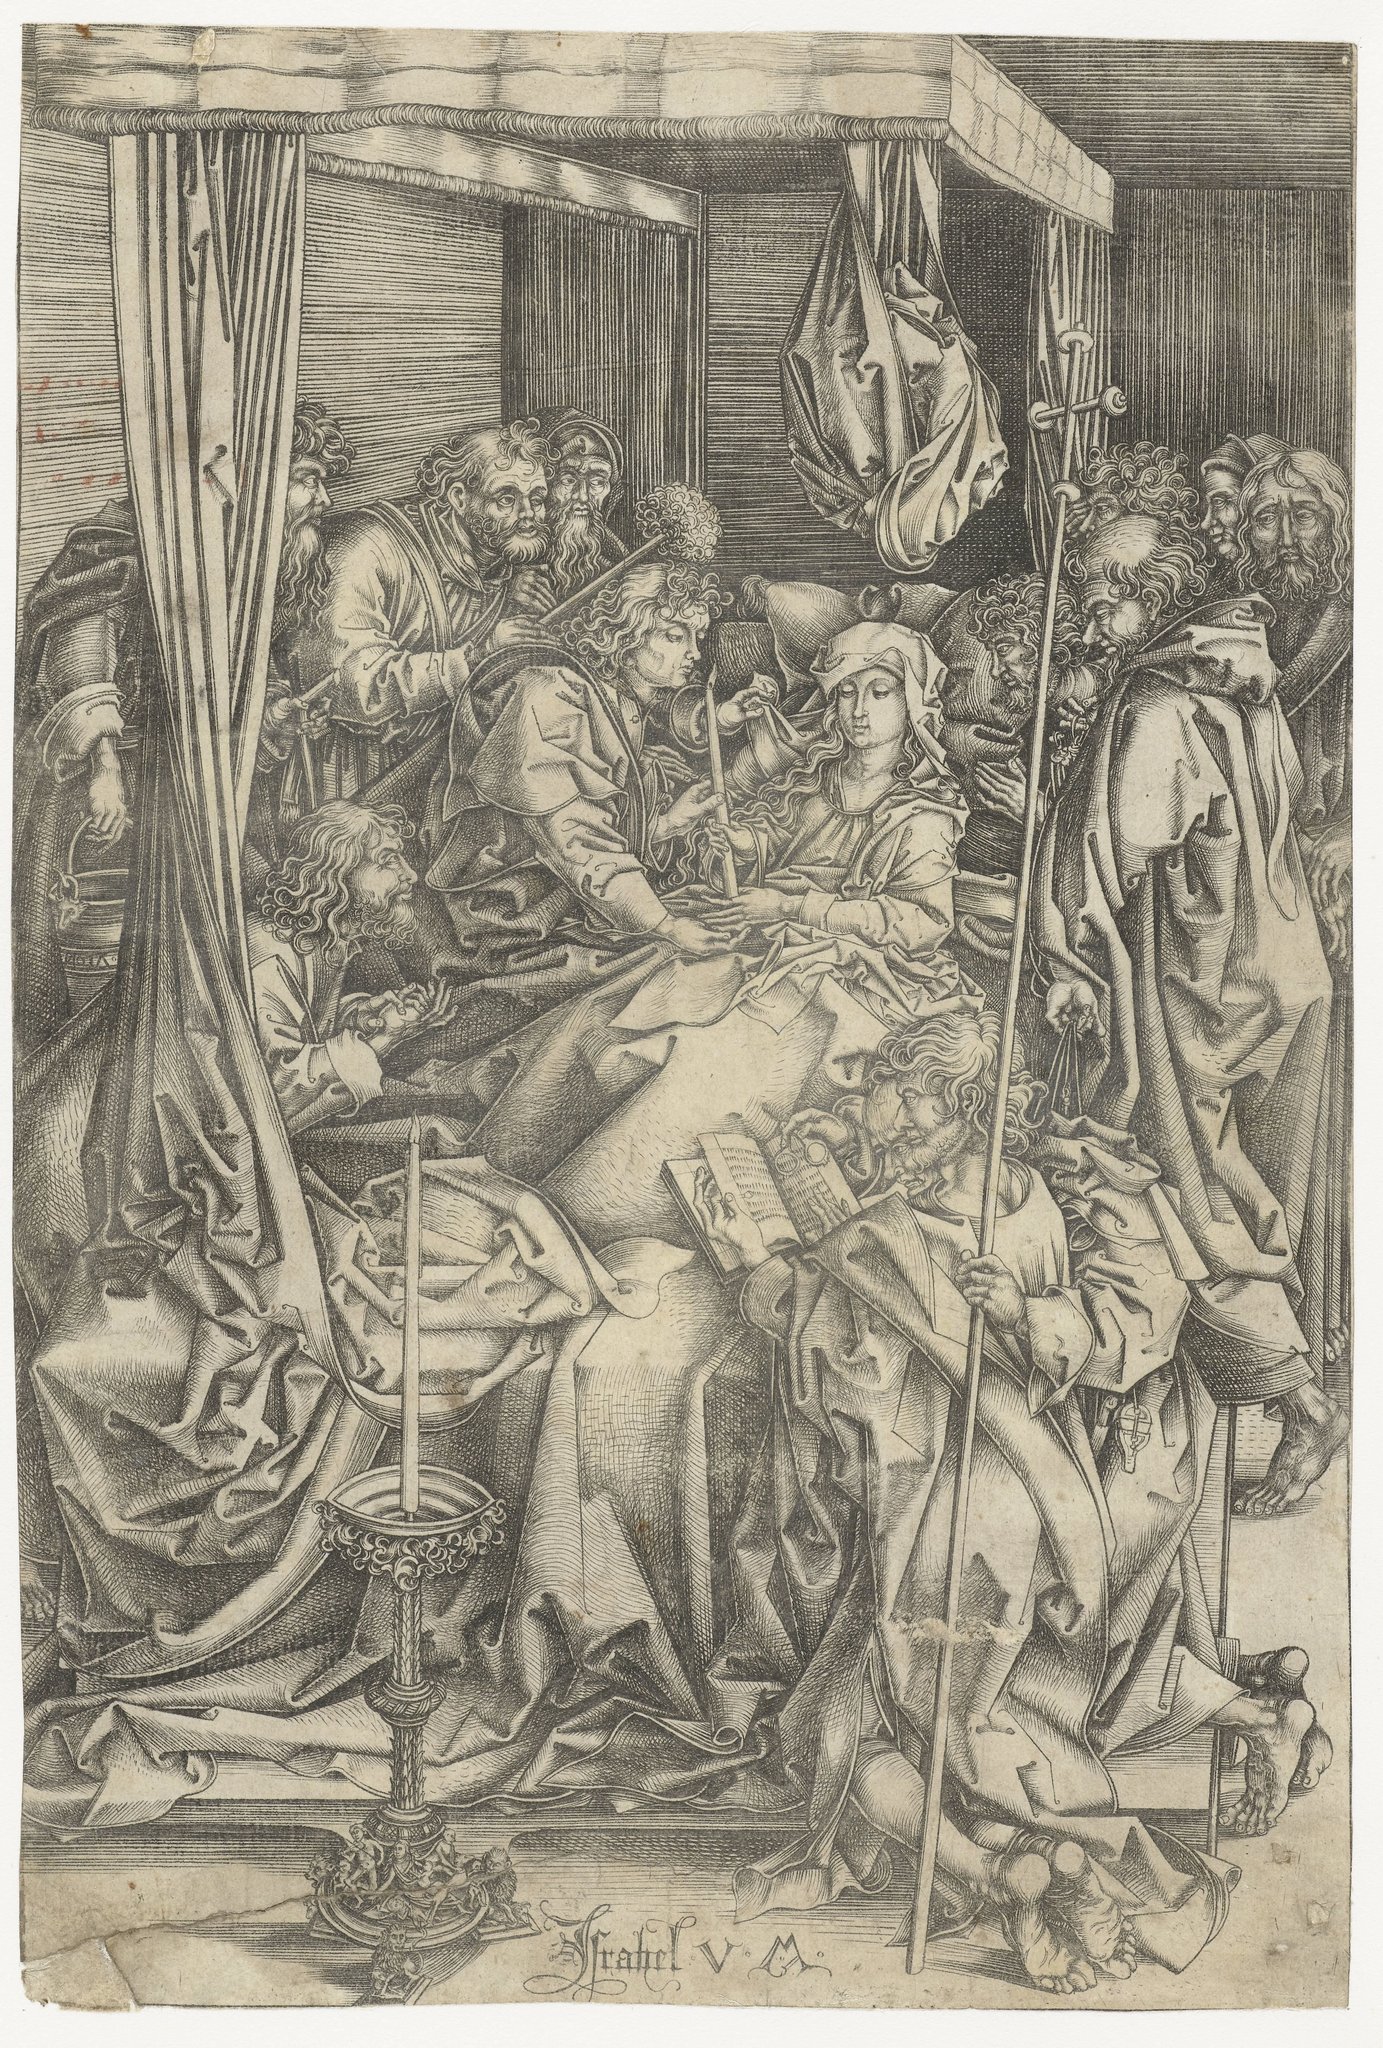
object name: print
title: De dood van Maria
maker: israhel van meckenem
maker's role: print maker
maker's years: 1440-1517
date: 1455-1503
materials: paper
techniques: engraving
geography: bocholt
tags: the dormition: mary on her deathbed; the apostles are gathered around her (john the evangelist may be shown sleeping or dreaming), bed with tester, chandelier, candelabrum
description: Maria ligt in een groot hemelbed, omringd door de twaalf apostelen. Op de voorgrond een kaars op een grote standaard.